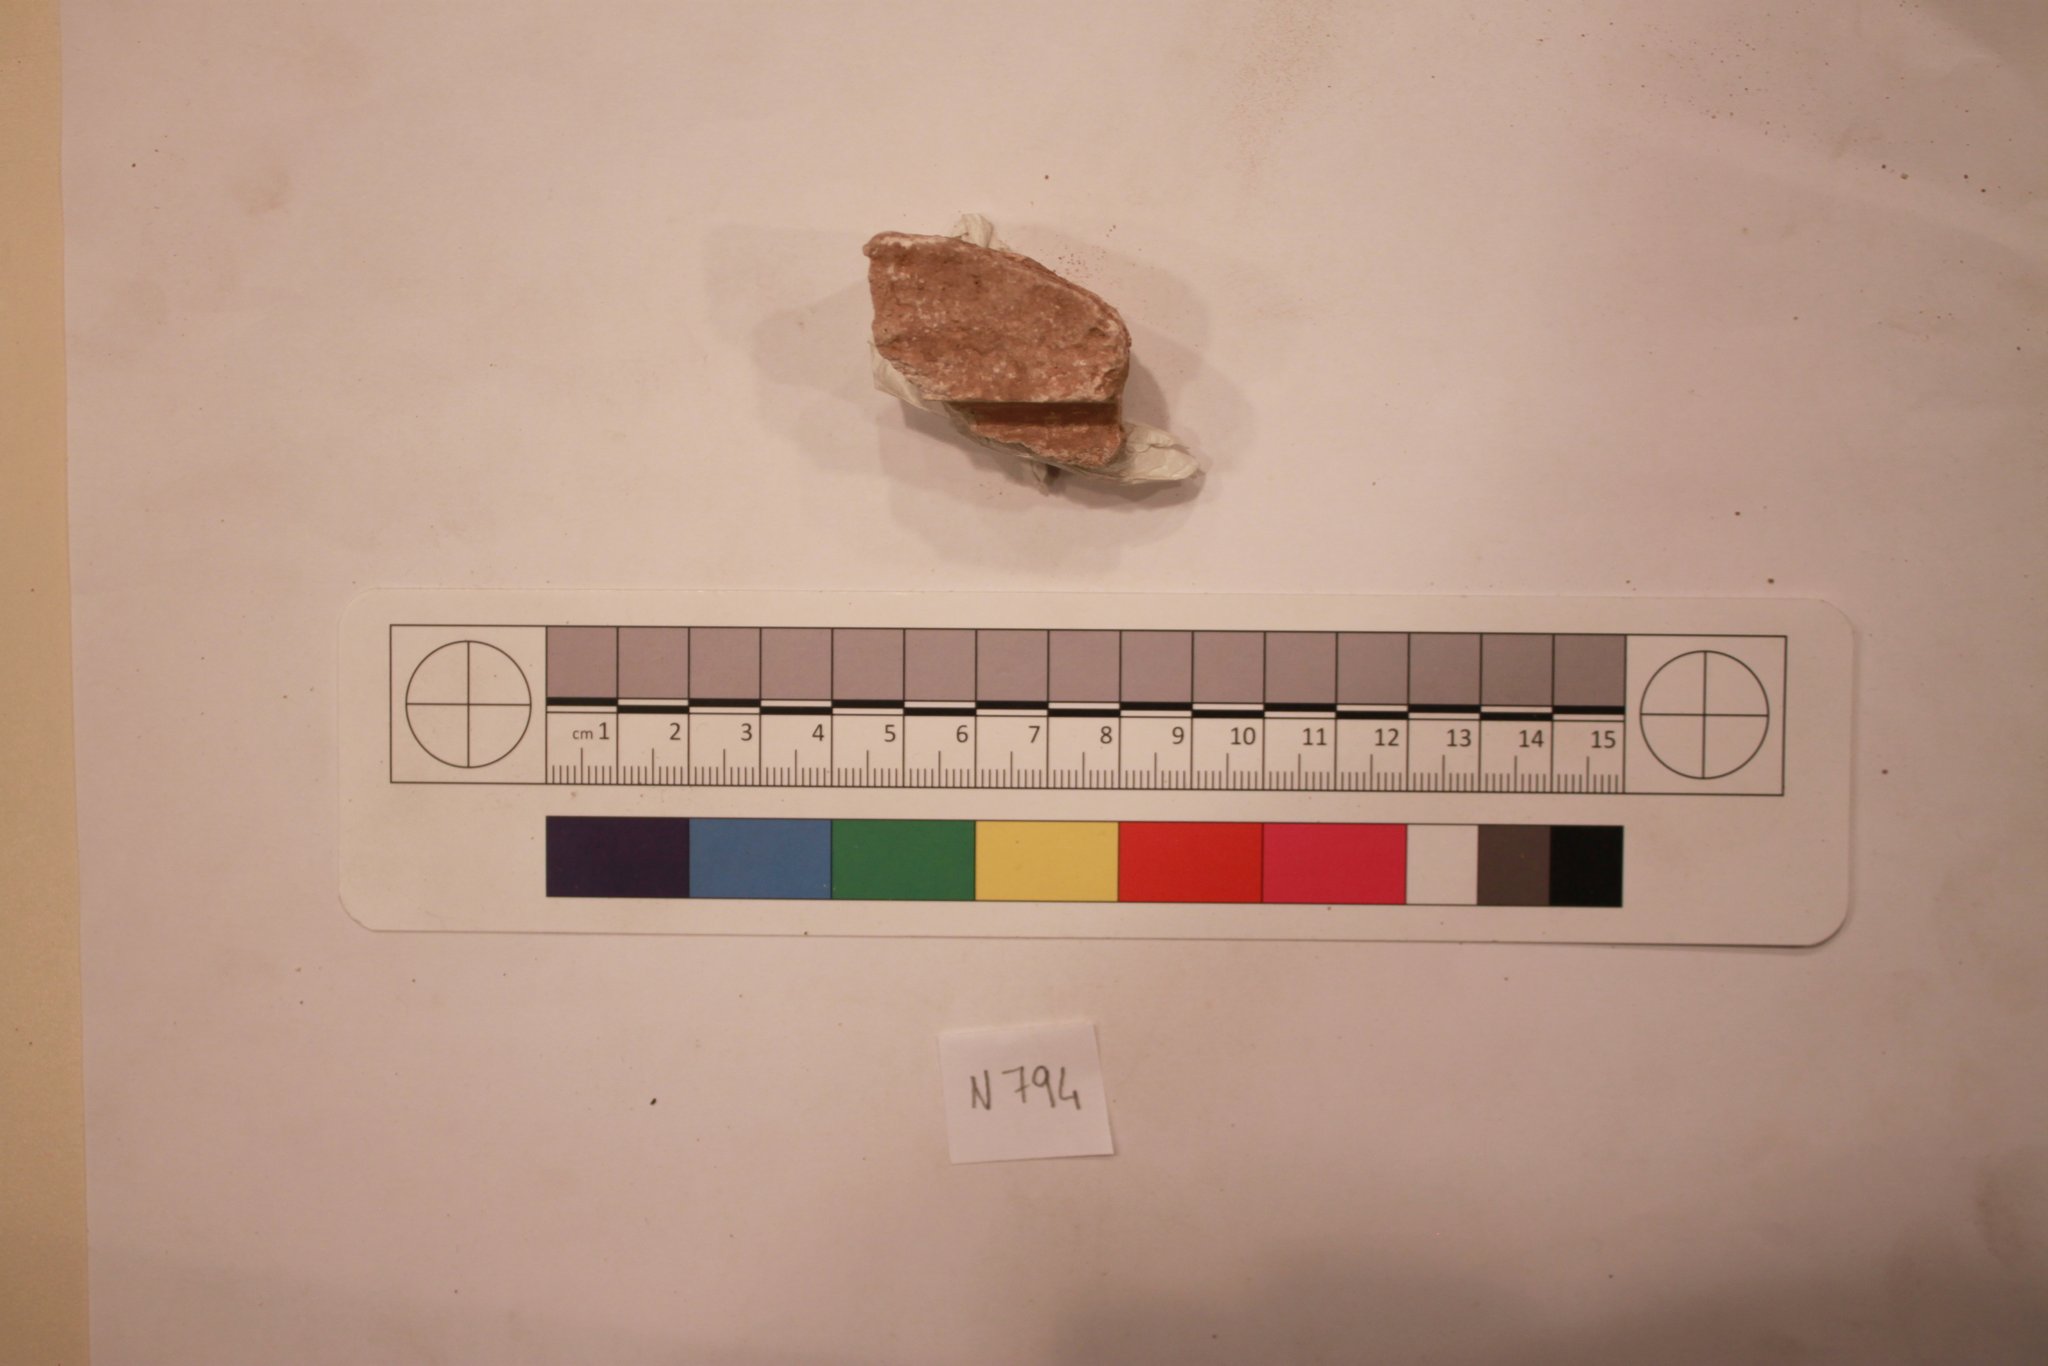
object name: fragment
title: Stucco Fragment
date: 701-1200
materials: plaster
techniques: carving, painting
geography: iran